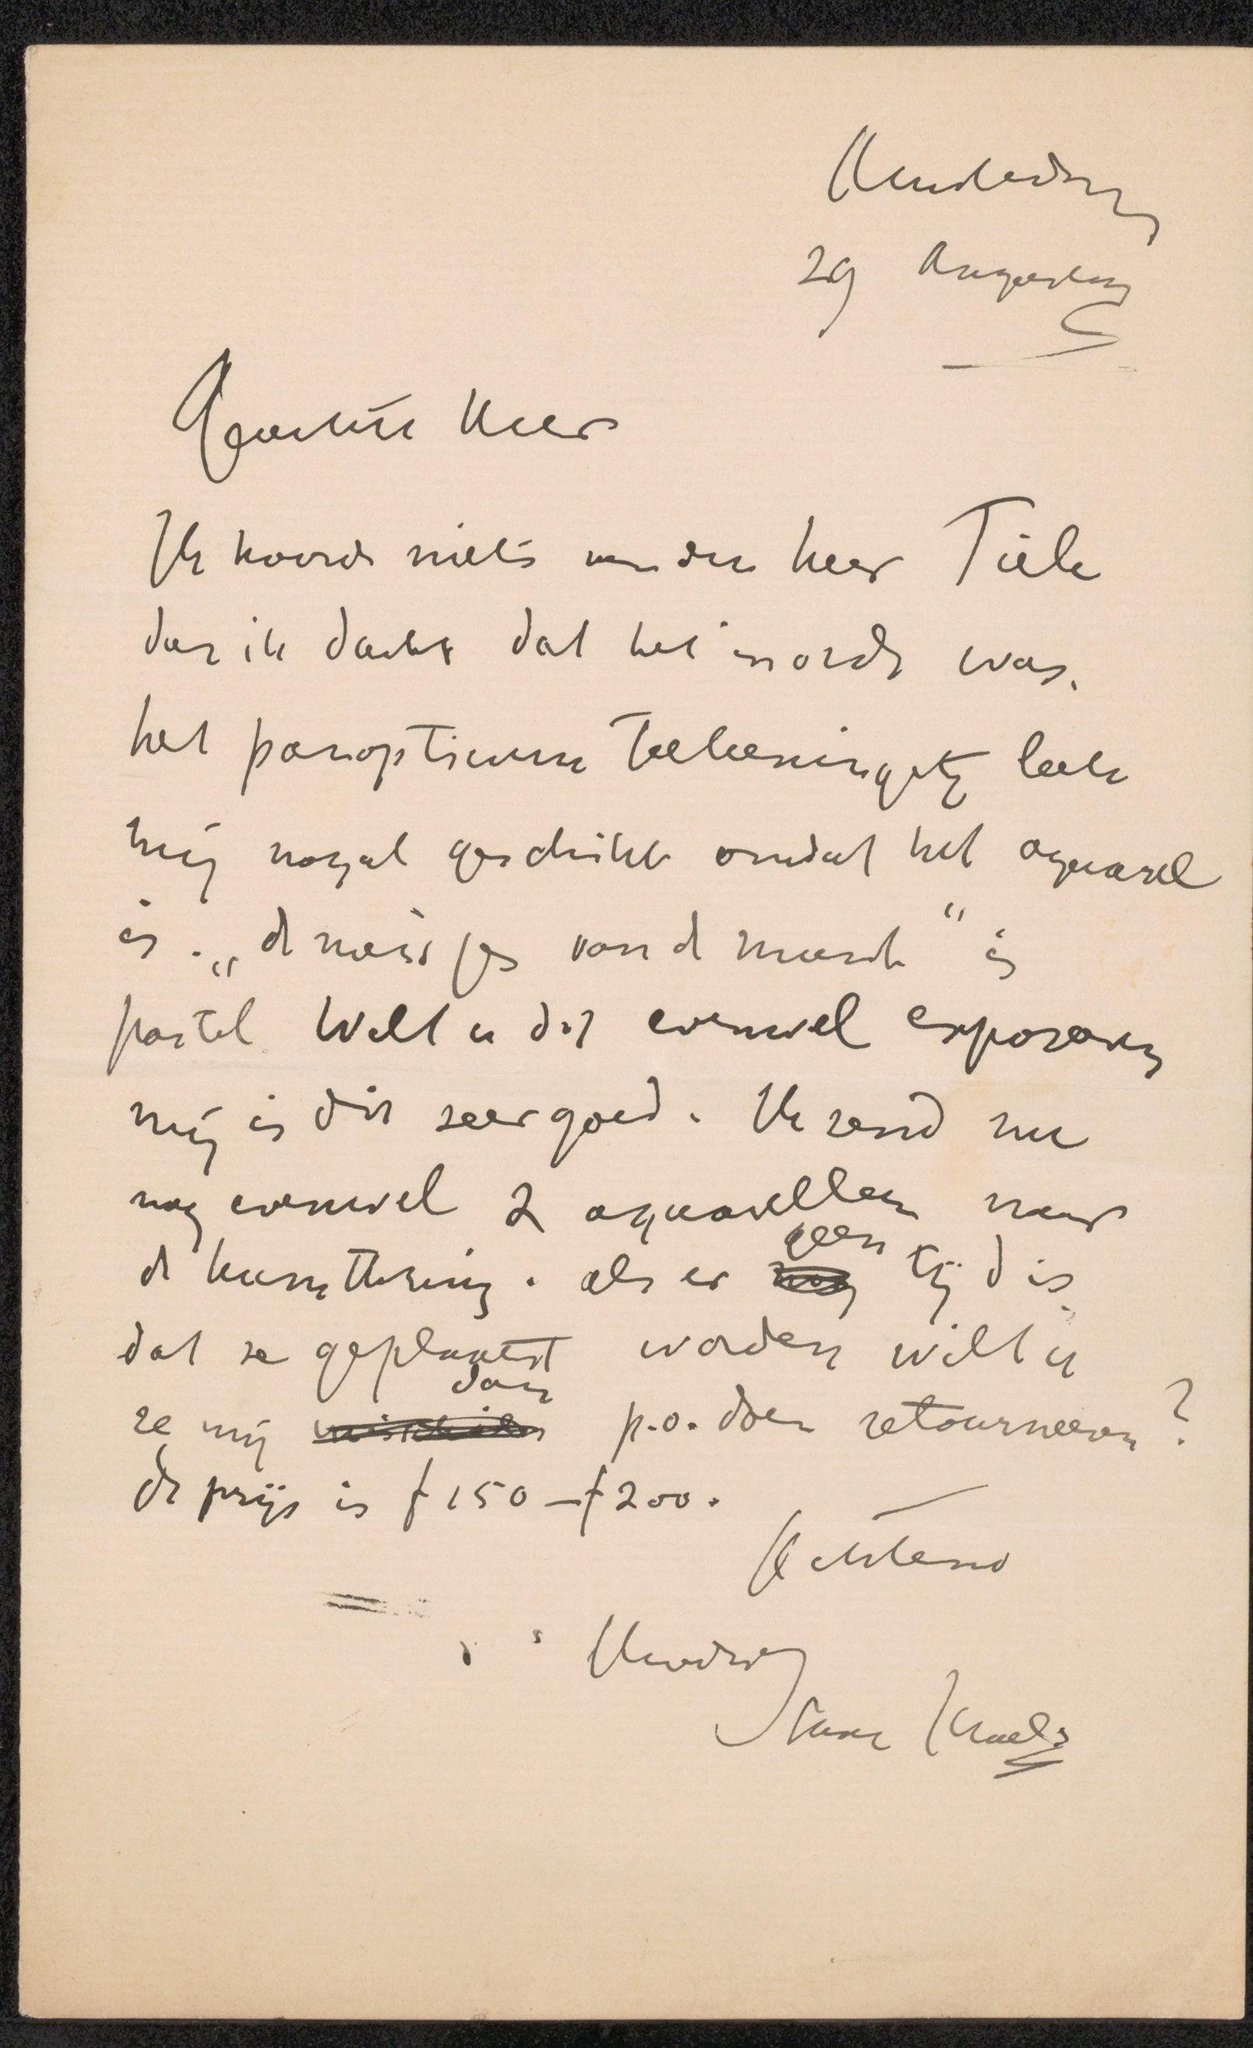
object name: letter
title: Brief aan Pieter Haverkorn van Rijsewijk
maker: isaac israels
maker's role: draughtsman, painter, print maker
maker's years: 1865-1934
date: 1875-1915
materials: ink, paper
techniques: pen, writing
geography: amsterdam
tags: leiden, pieter haverkorn van rijsewijk, drawing, exhibition ~ art, money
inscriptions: collector's mark: ‘RPK’